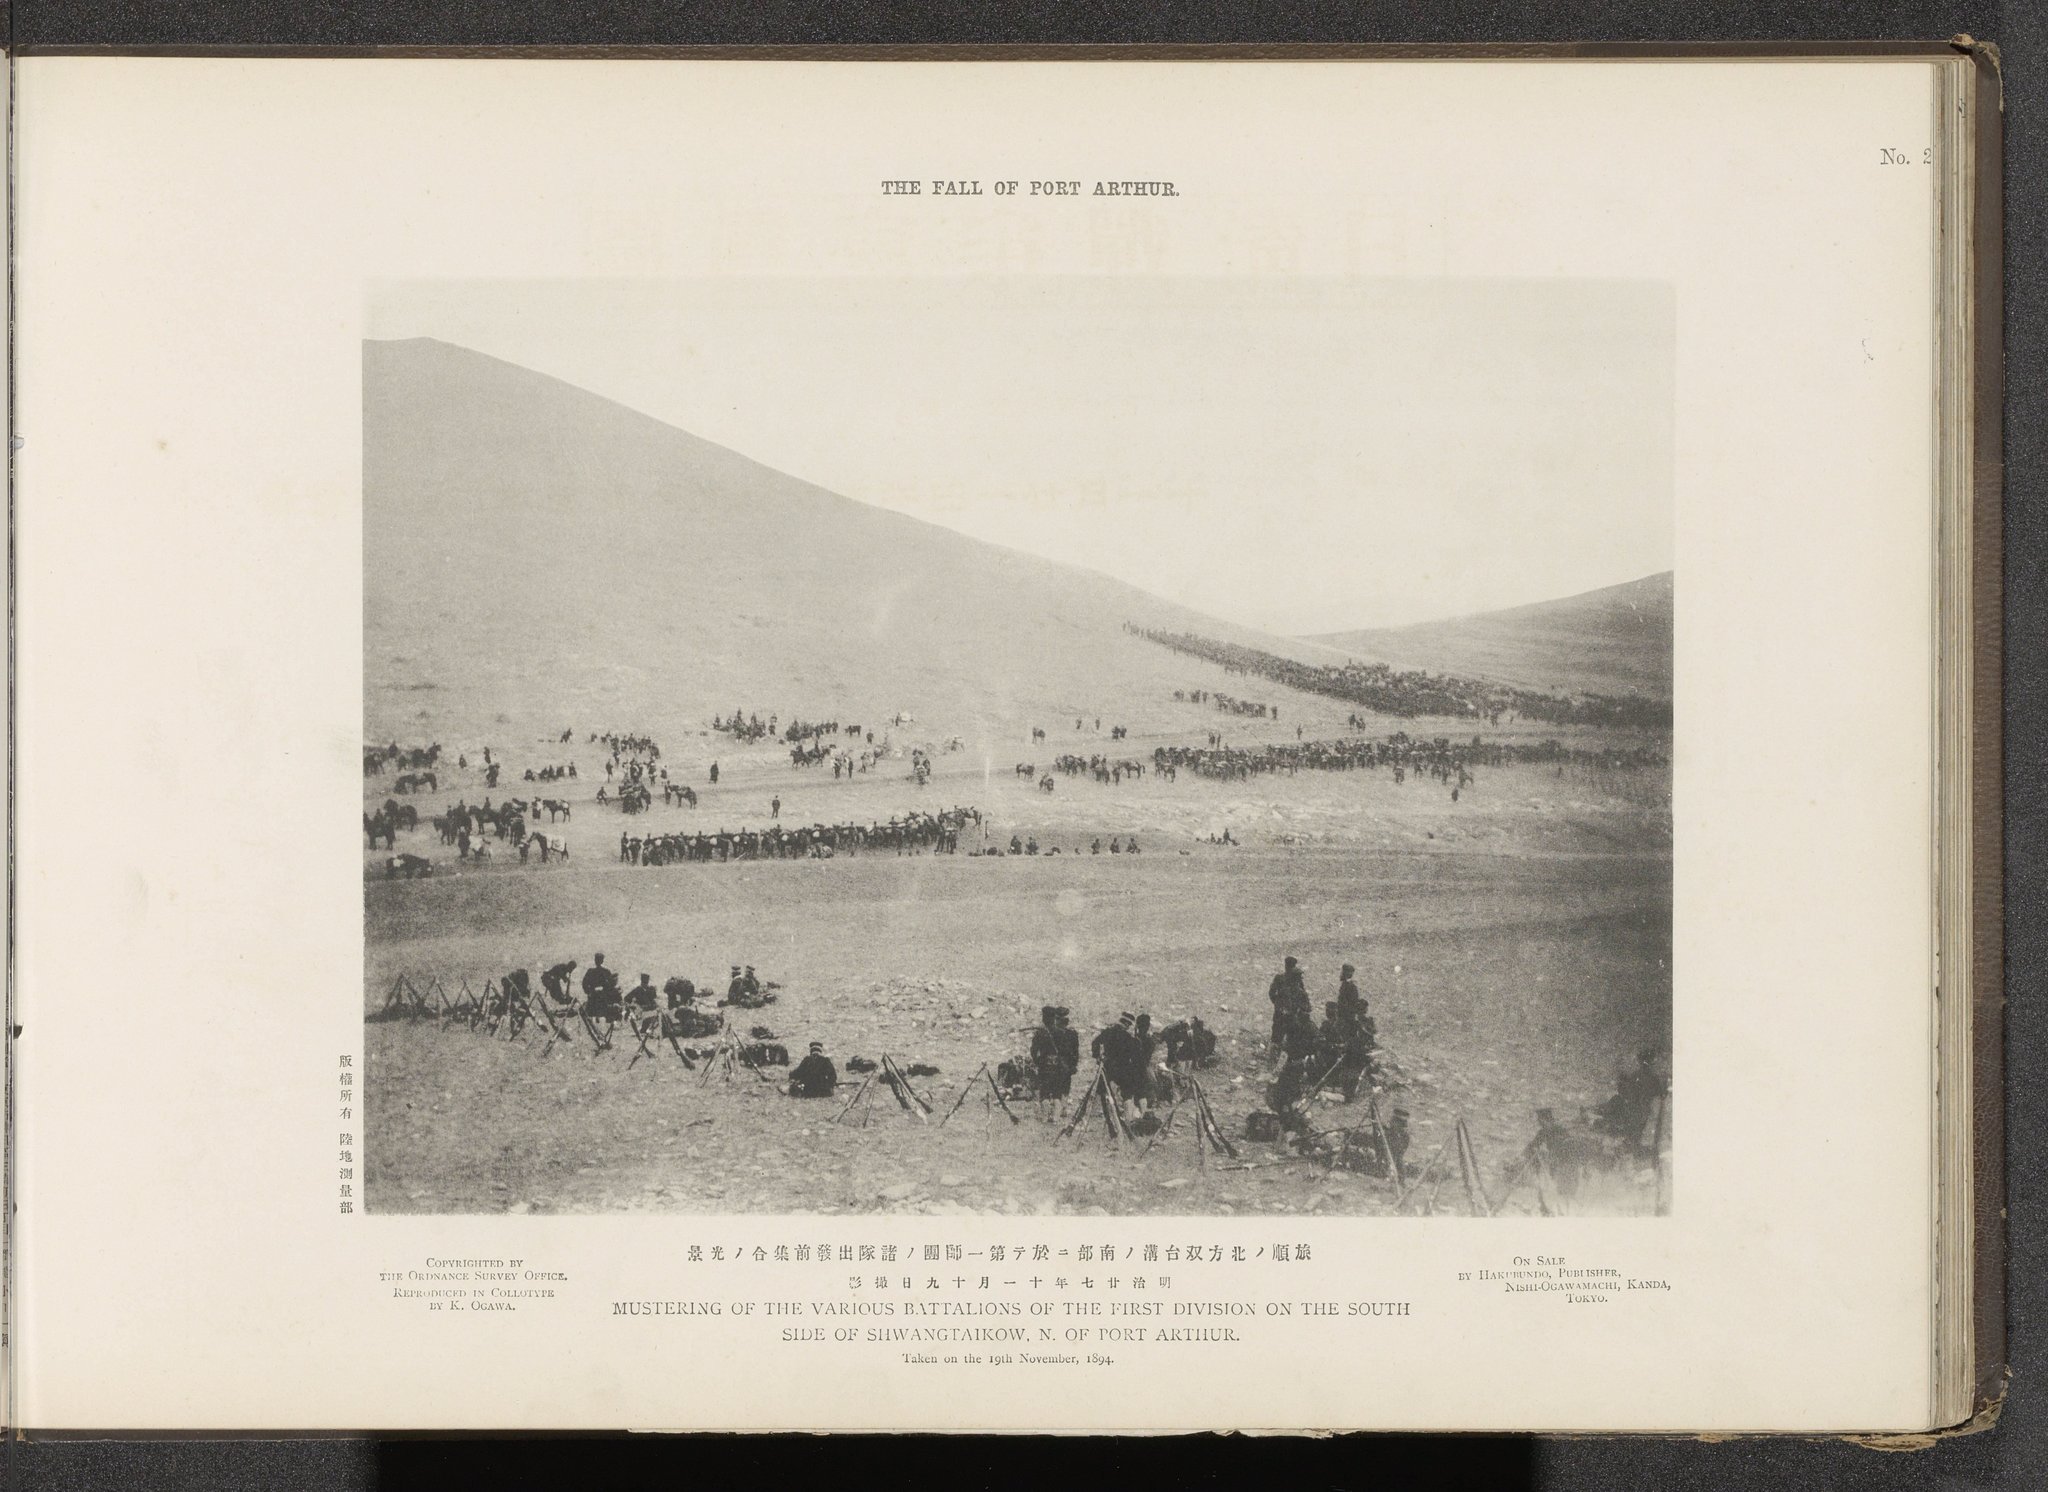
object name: page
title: Mustering of the various battalions of the first division on the south side of Shwangtaikow, N. of Port Arthur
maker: kazumasa ogawa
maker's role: auteur, fotograaf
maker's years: 1860-1929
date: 1894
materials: paper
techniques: photograph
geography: manchuria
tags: low hill country, division of armed forces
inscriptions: inscription: ‘The fall of Port Arthur.’, number: ‘No. 2’, name: ‘On sale by Hakubundo, Publisher, Nishi-Ogawamachi, Kanda, Tokyo.’